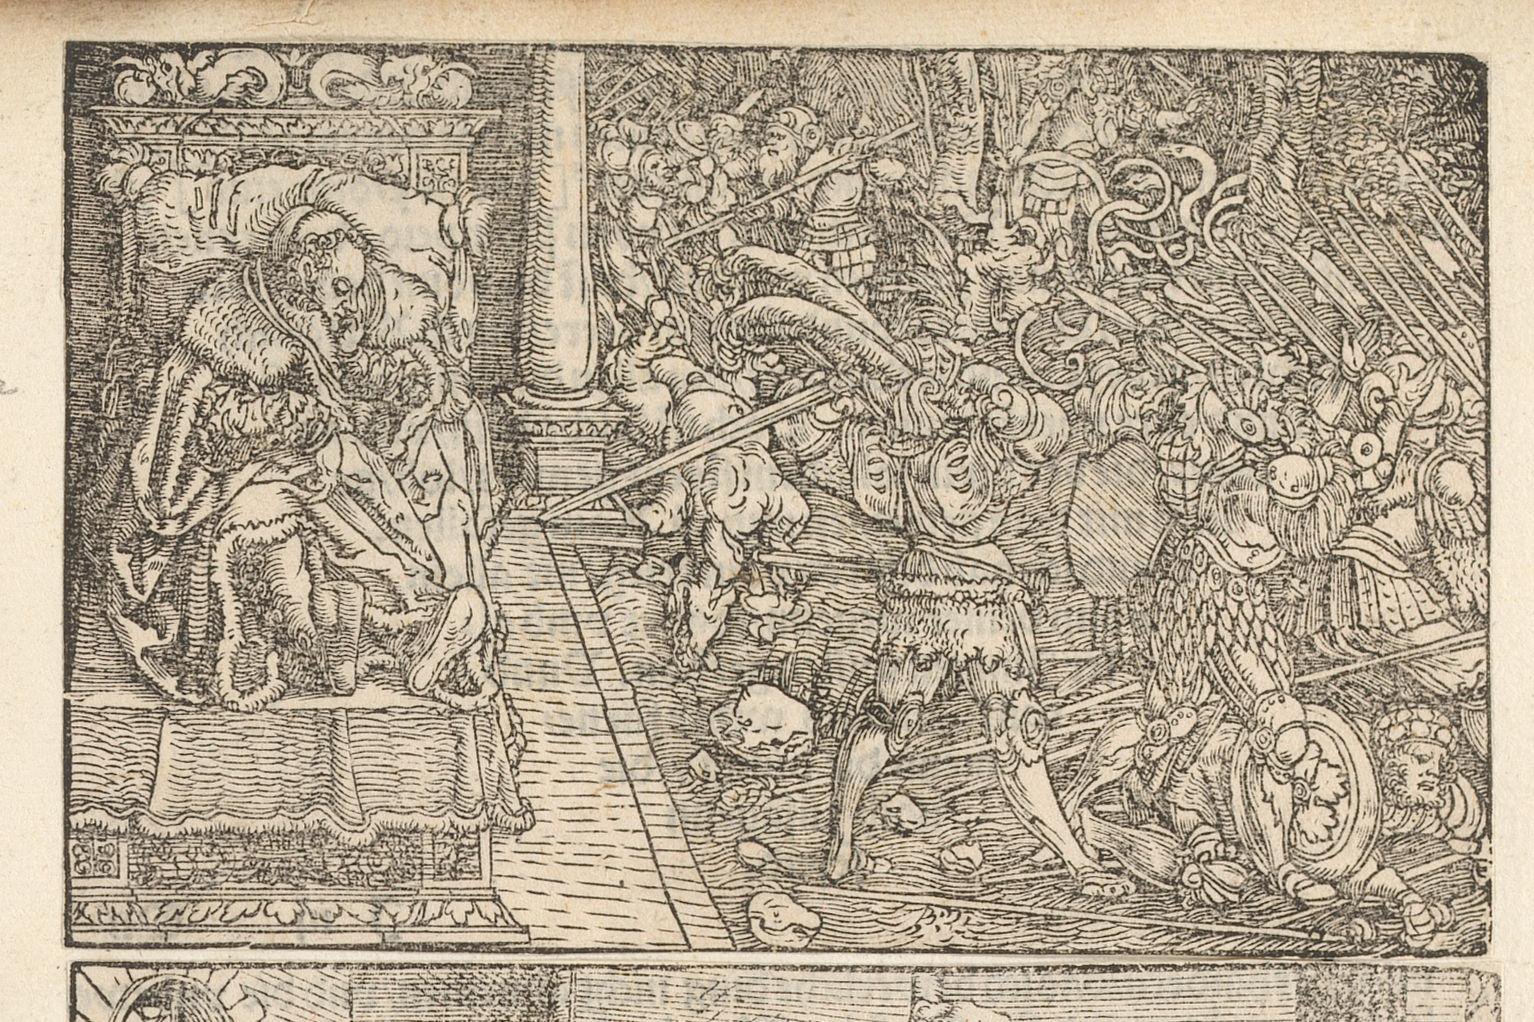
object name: print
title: Slapende man op een bed droomt over een slagveld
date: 1514-1532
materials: paper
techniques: letterpress printing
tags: battle, sleeping in bed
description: Deze prent is gebruikt in: Petrarca, Francesco. Von der Artzney bayder Glück, des guten und widerwertigen: unnd weß sich ain yeder inn Gelück und Unglück halten sol (...). Augsburg: Heinrich Steiner, 1532. Deze uitgave is ook bekend onder de titel 'Trostspiegel in Glück und Unglück'. Deze prent is ook gebruikt in: Cicero, Marcus Tulius. Officia M.T.C. Ein Buch so Marcus Tullius Cicero der Römer zu seynem (...). [Vertaald uit het Latijn door] Johann von Schwarzenberg. Augsburg: Heinrich Steiner, 1531.